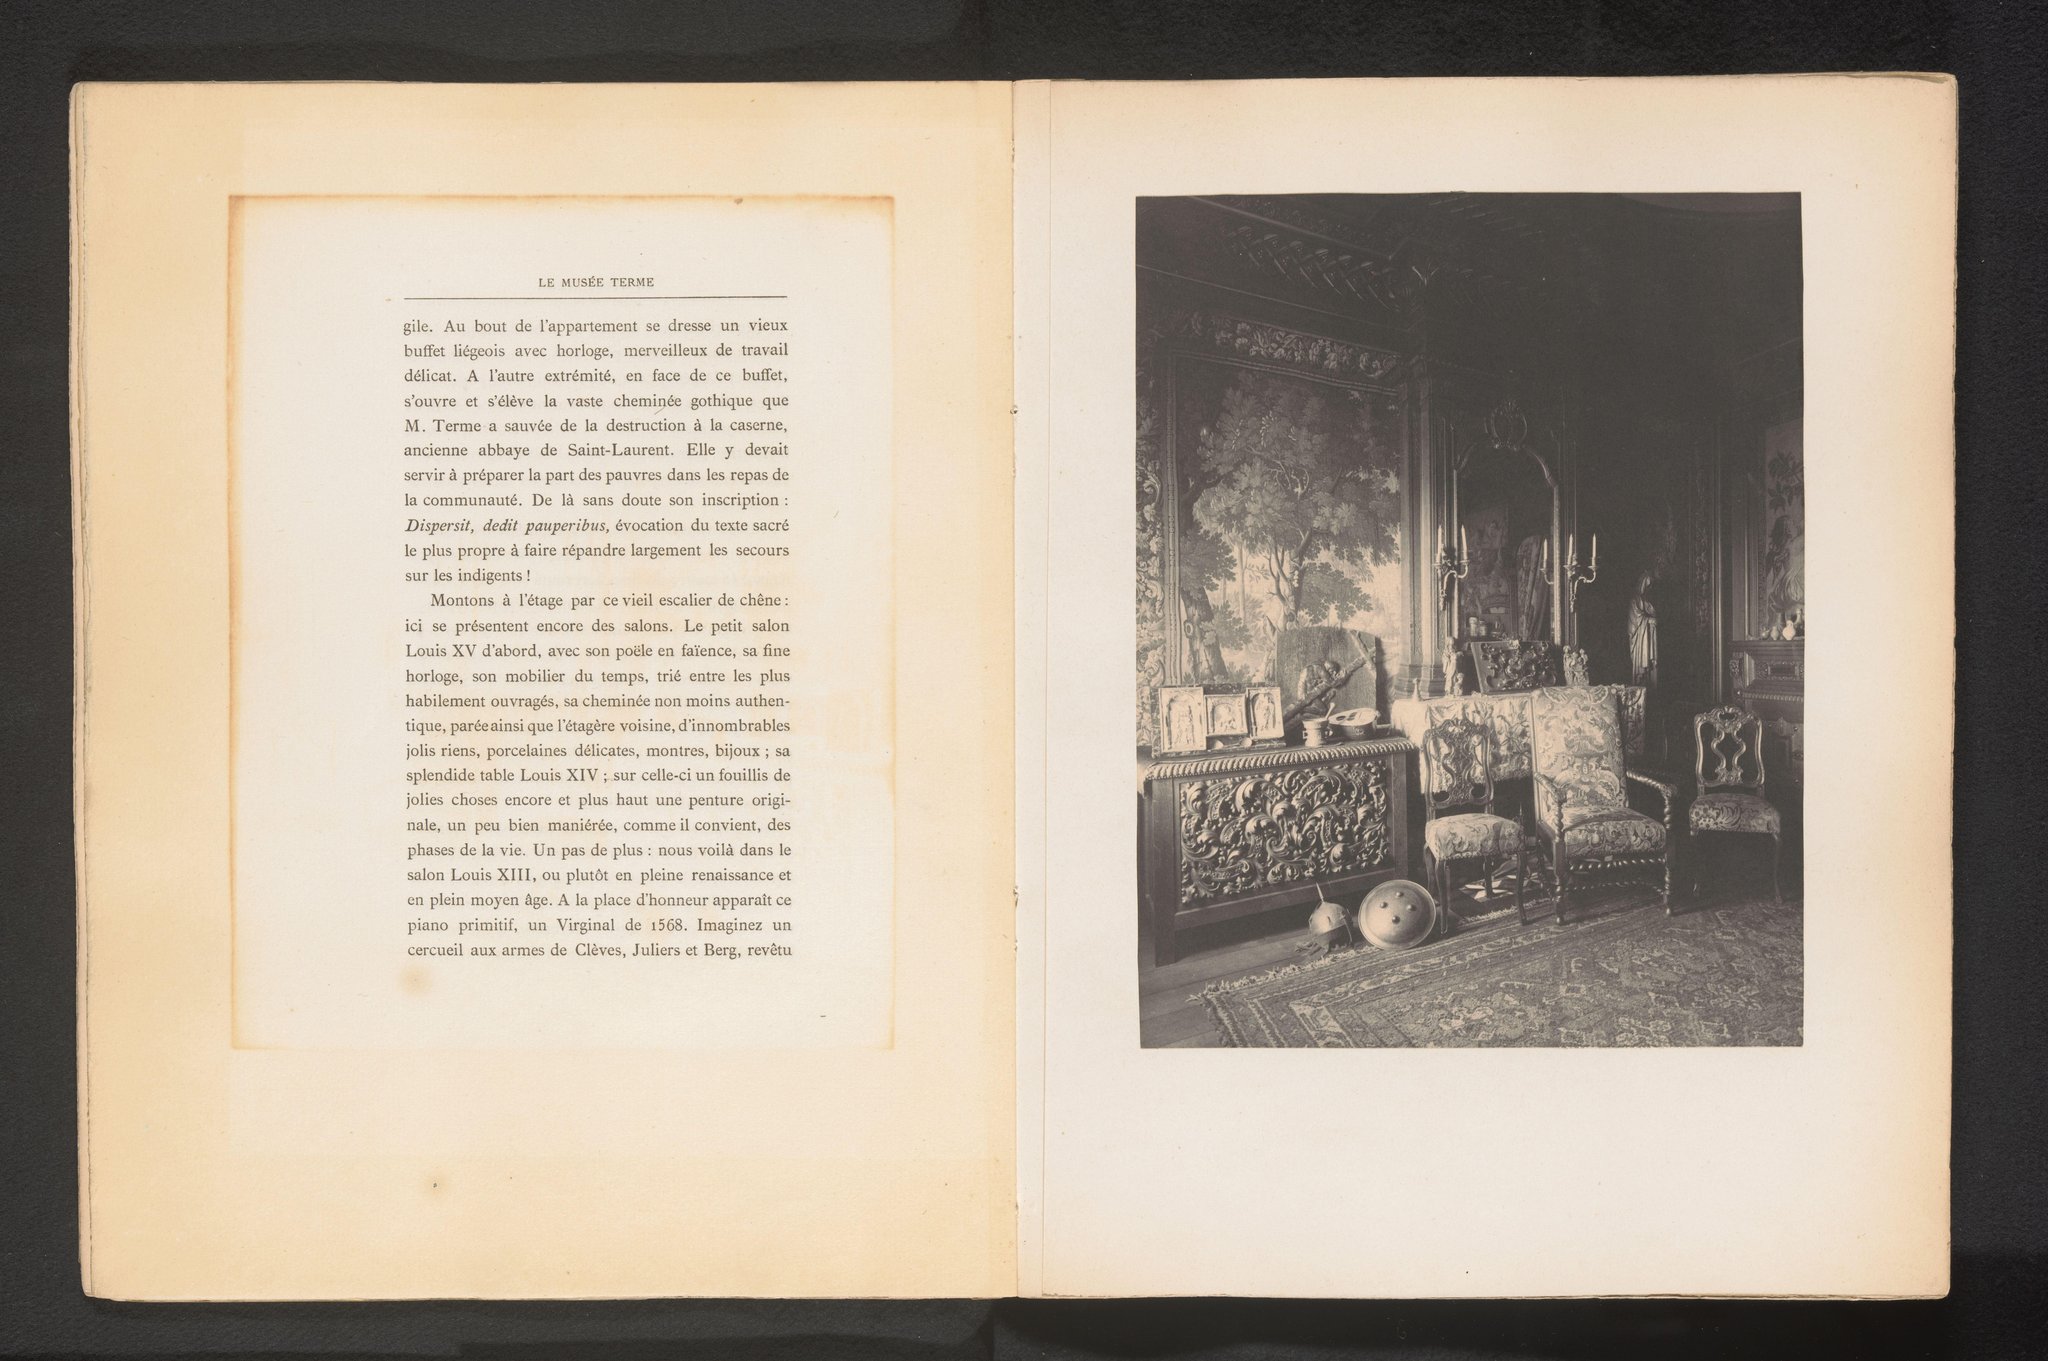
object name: page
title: Kamer in het huis van Antonin Terme met zijn collectie antiquiteiten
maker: Anonymous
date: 1880-1885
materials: photographic support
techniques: platinum process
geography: liège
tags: art collection, art gallery, 'kunstschrank', other rooms